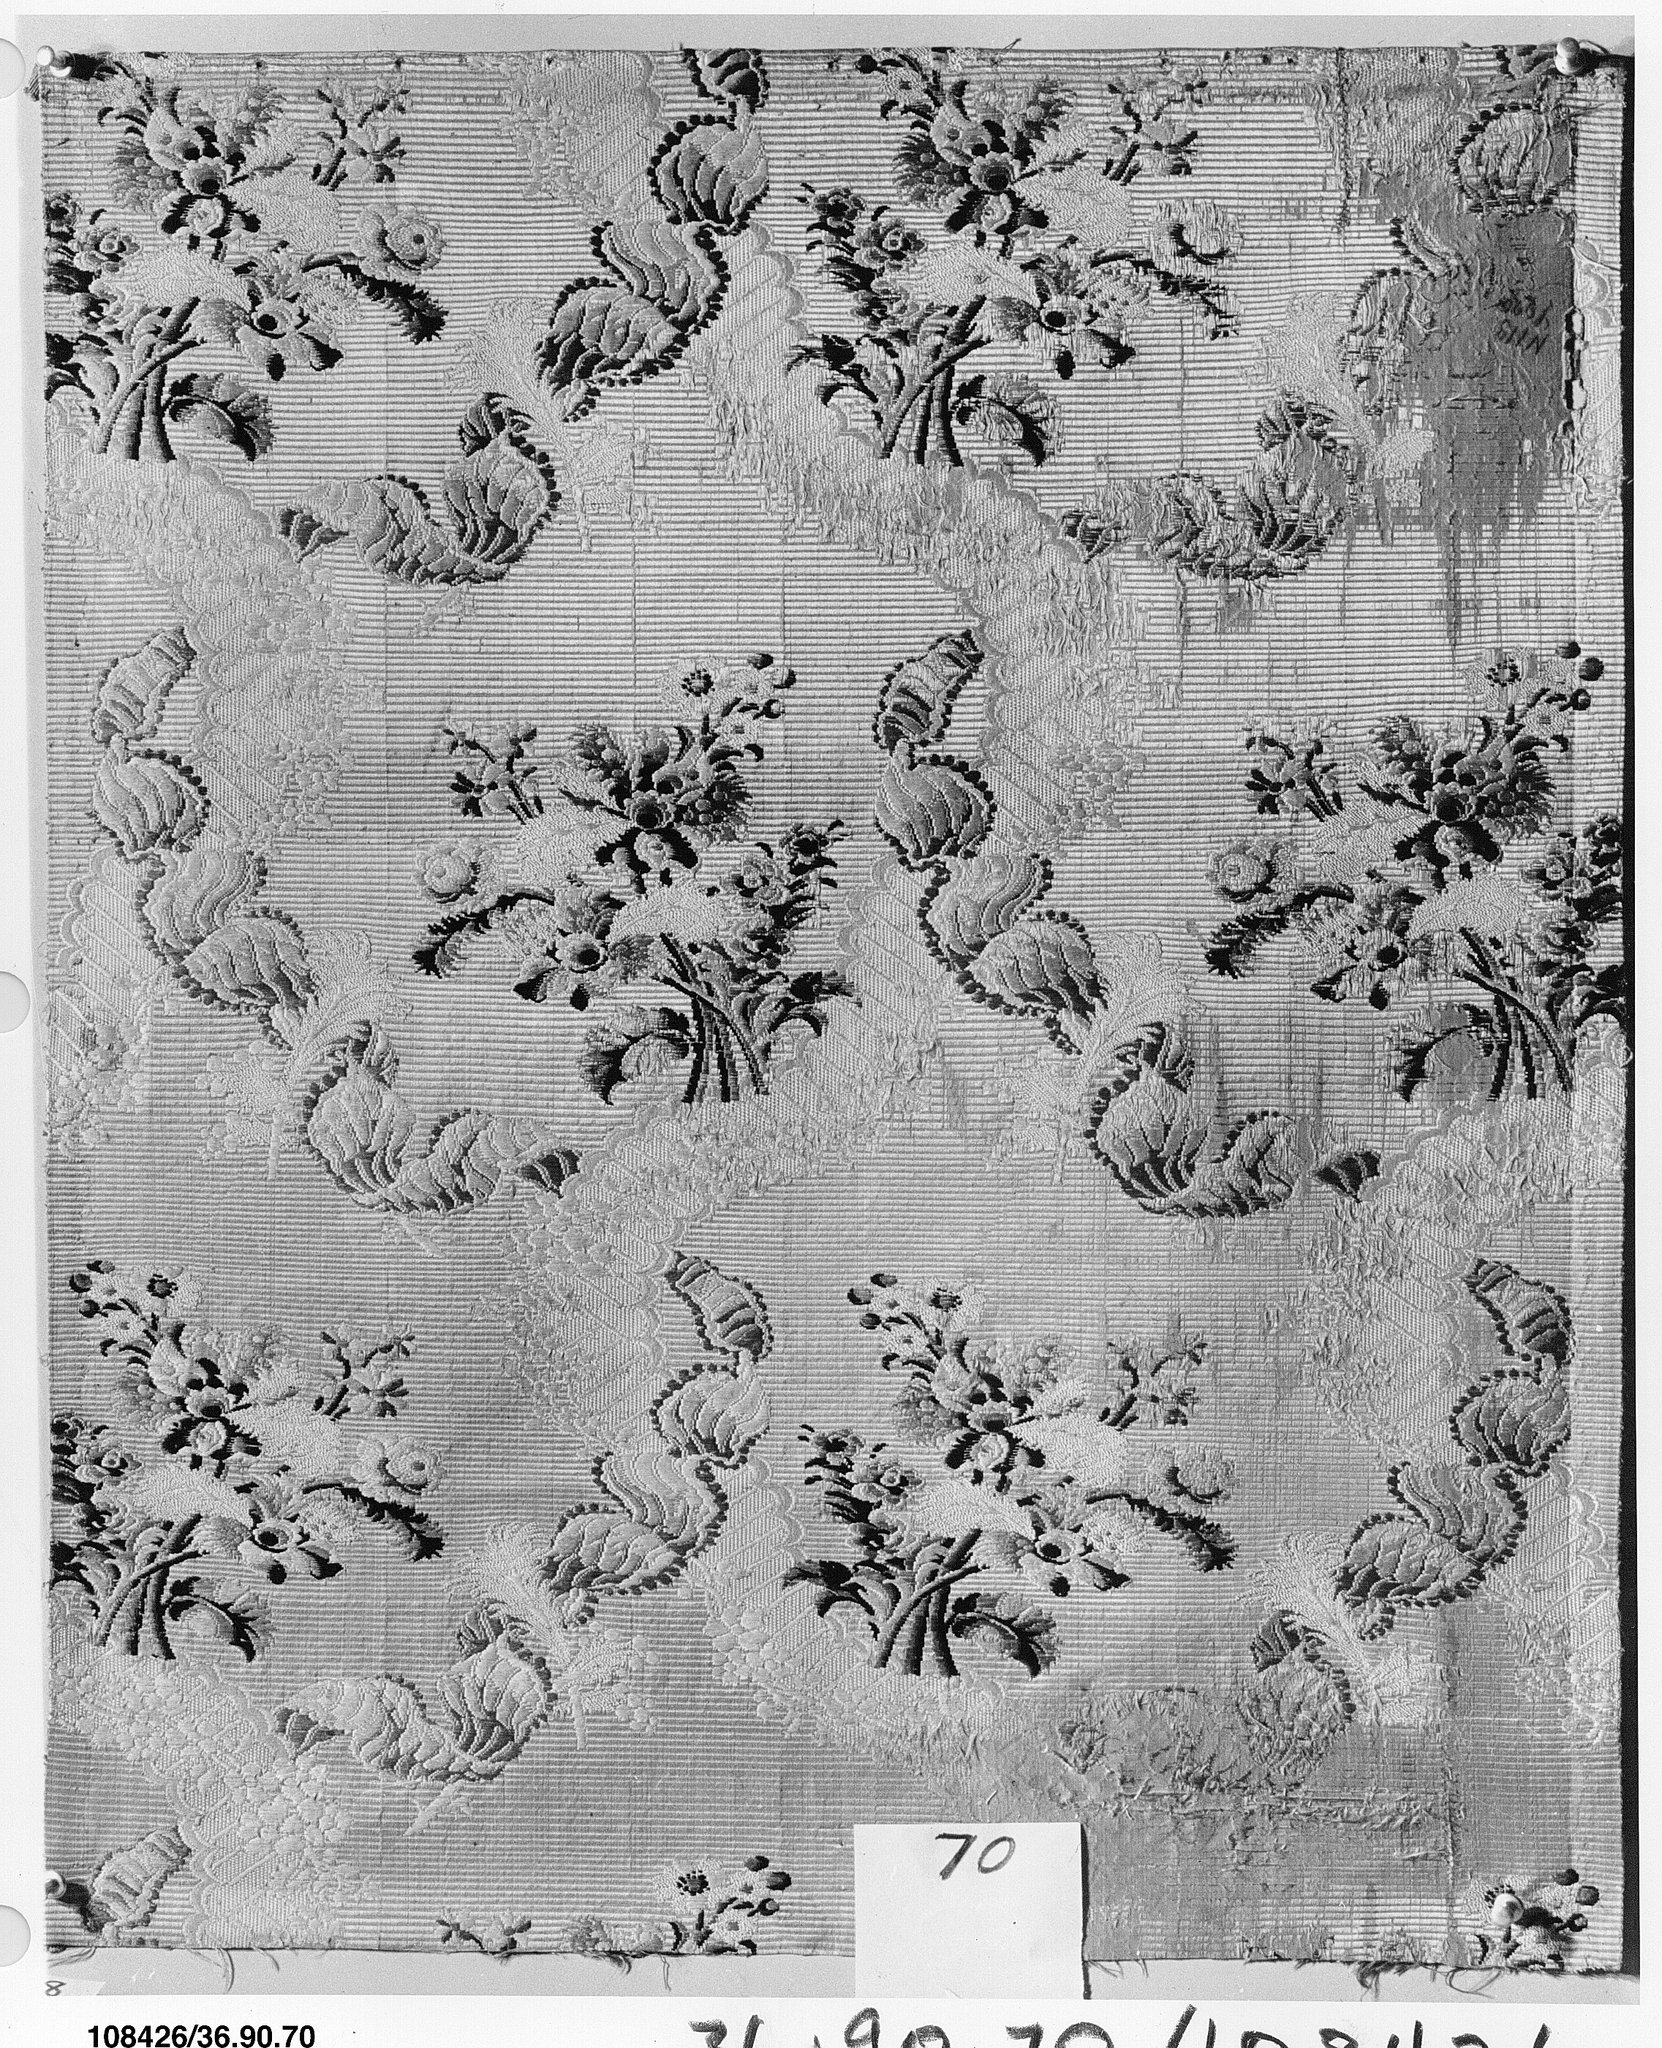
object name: piece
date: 1734-1766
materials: silk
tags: flowers